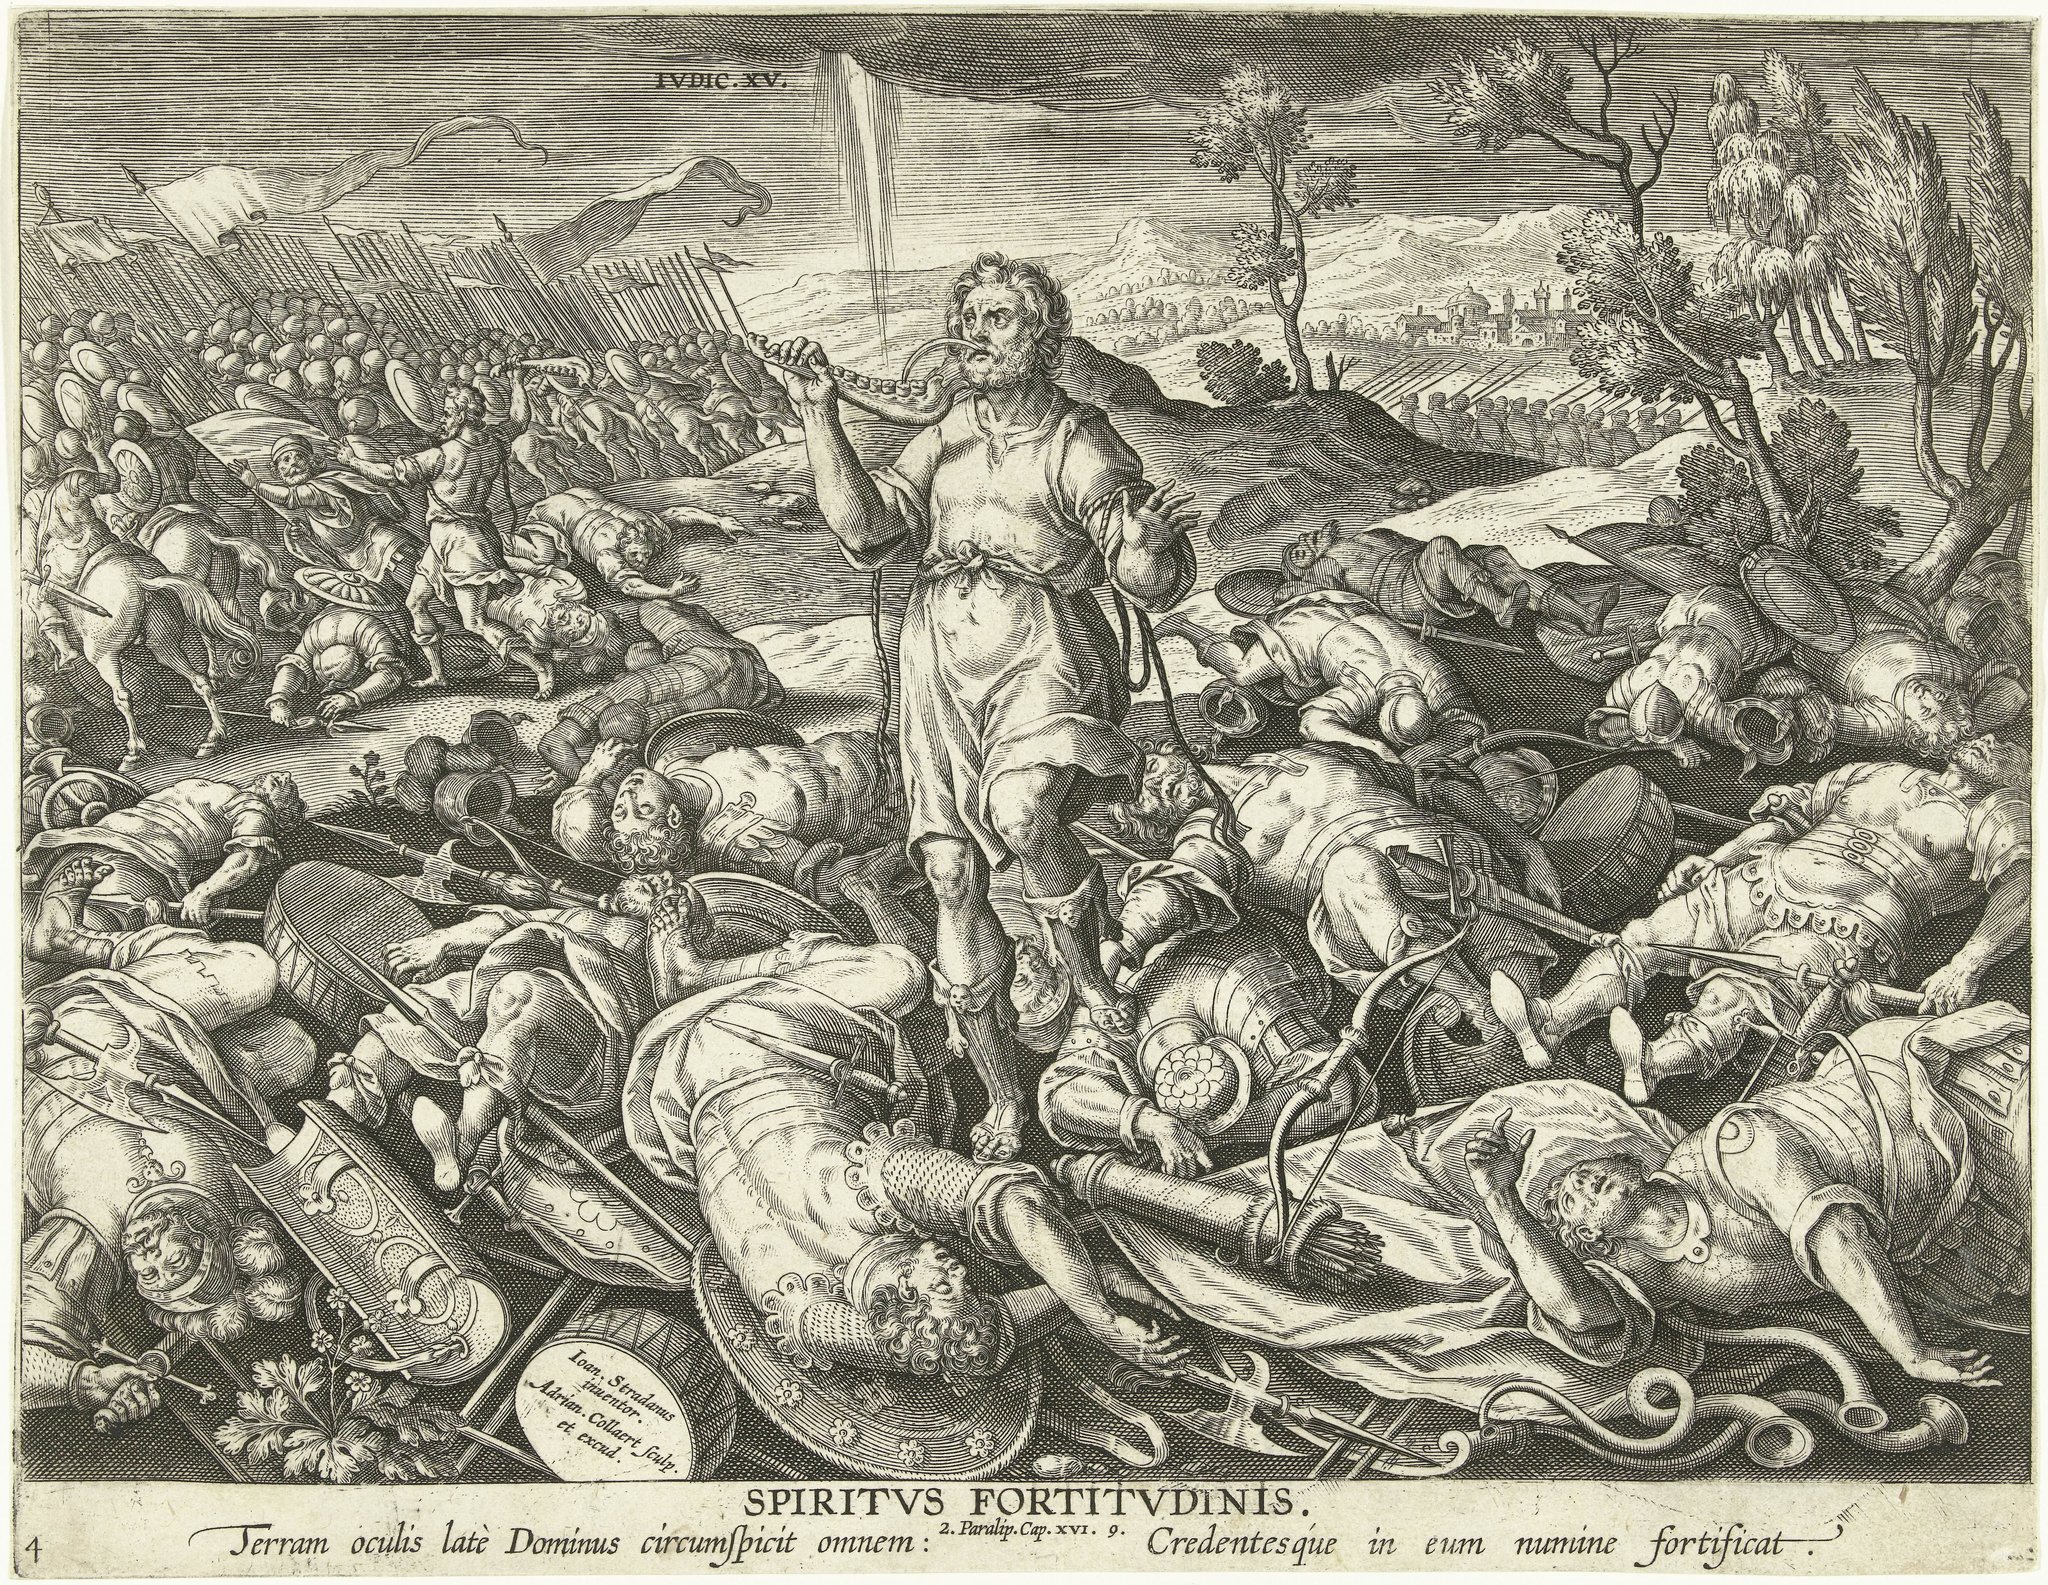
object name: print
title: Spiritvs Fortitvdinis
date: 1593-1597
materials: paper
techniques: engraving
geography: antwerp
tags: with an ass's jaw-bone samson slays a thousand philistines, samson drinks water from a well after having slain a thousand philistines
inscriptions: collector's mark: Lugt 2228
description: Simson verslaat de Filistijnen (Rechters 15:14-16). De prent toont de passage waar Simson zijn goddelijke kracht demonstreert. Simson staat te midden van dode soldaten en heeft in zijn rechterhand de ezelskaak. In de verte vlucht de rest van het Filistijnse leger. God opent vervolgens de aarde en laat een bron opborrelen om Simson water te geven. De prent heeft een Latijns onderschrift. De prent is deel van een serie met de verschillende gaven van de Heilige Geest.